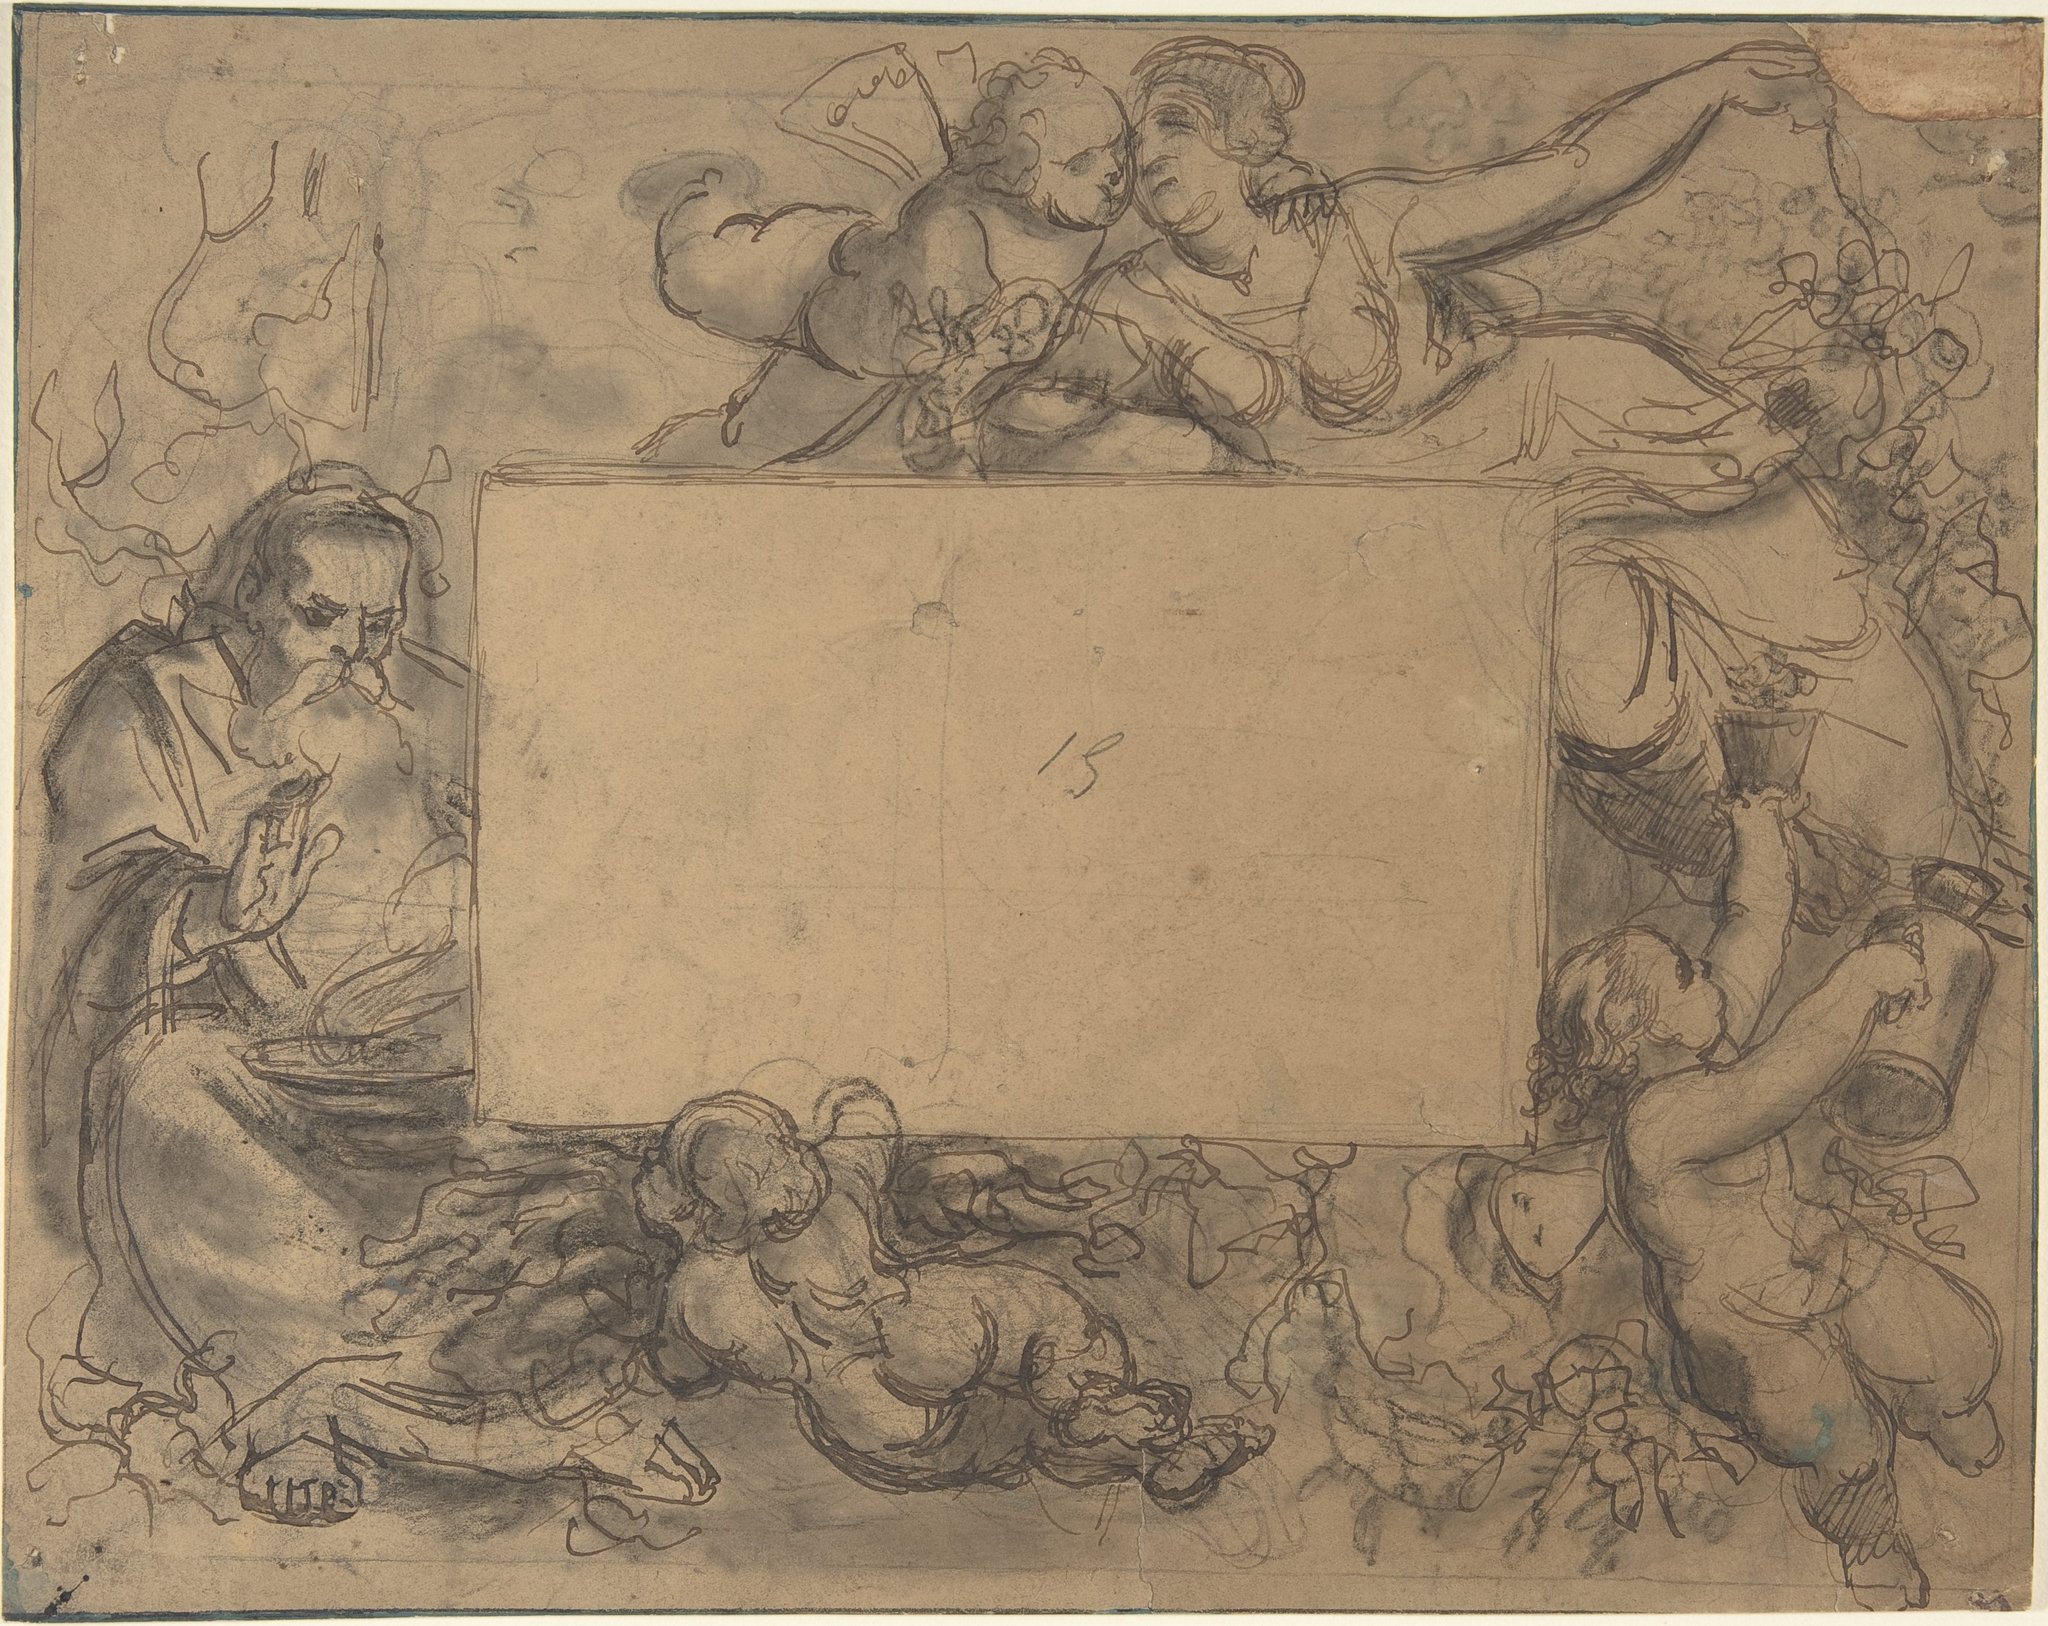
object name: drawing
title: Design for a Frame of a Ceiling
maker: anonymous, italian, 19th century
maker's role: artist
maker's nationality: italian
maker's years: 1800-1900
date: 1800-1900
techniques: pen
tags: men,women